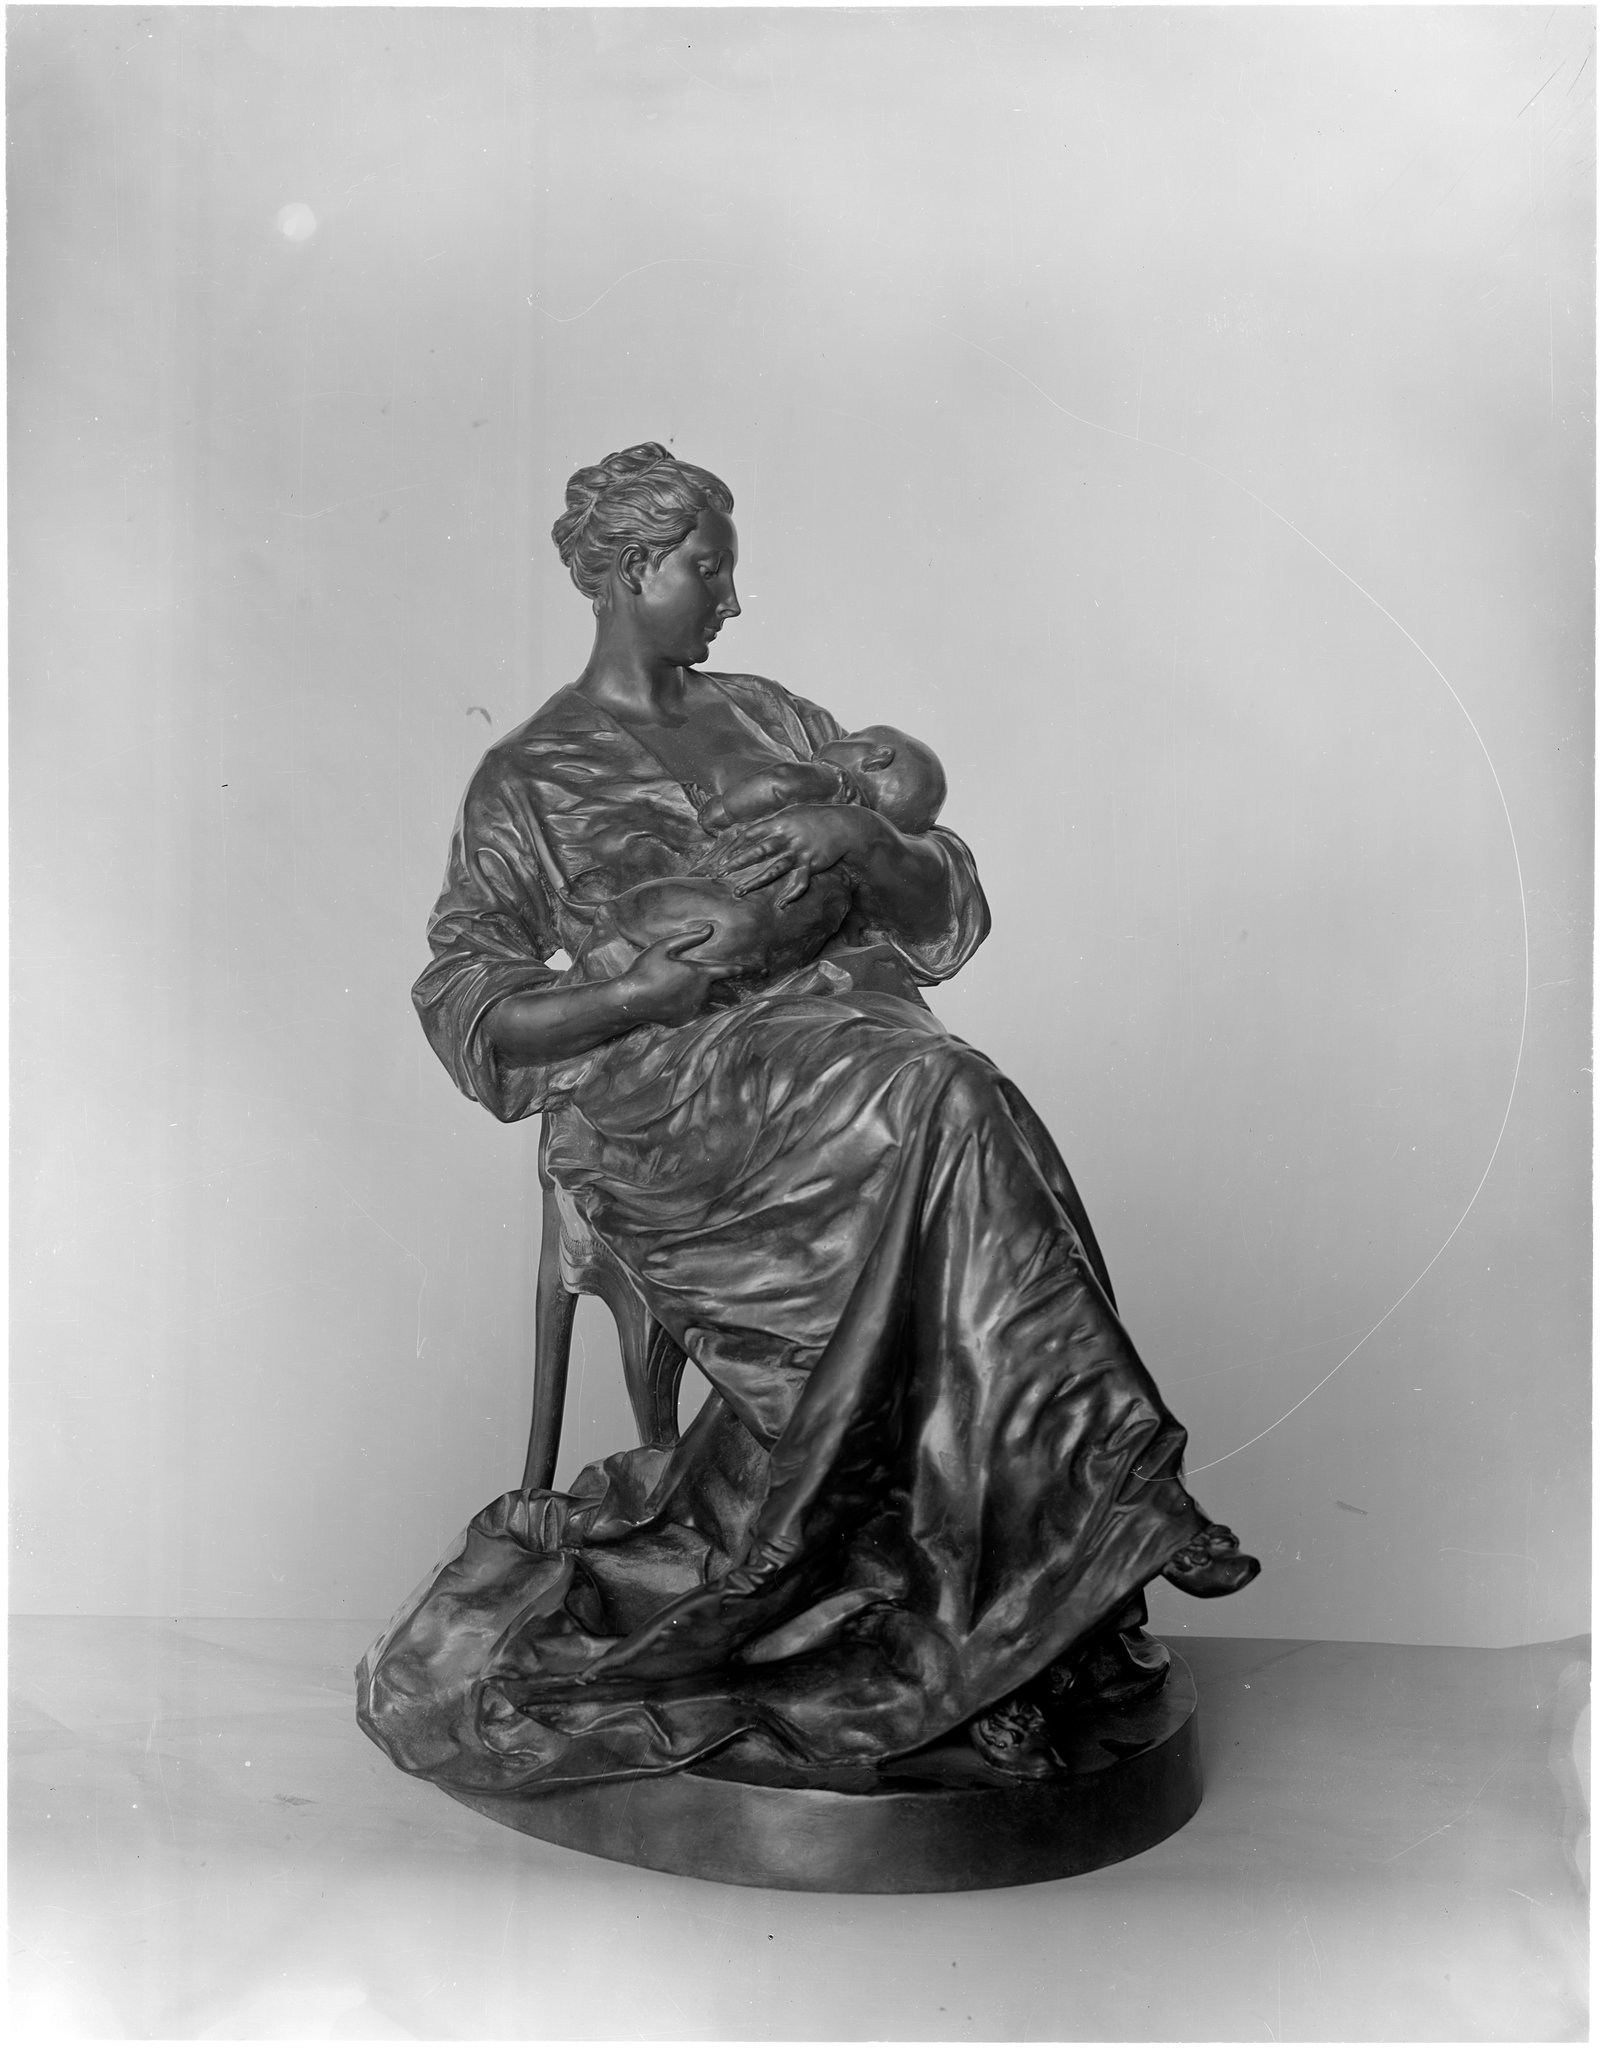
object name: statuette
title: The Young Mother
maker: aimé-jules dalou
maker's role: artist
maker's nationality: french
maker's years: 1838-1902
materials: bronze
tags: infants,mothers,women